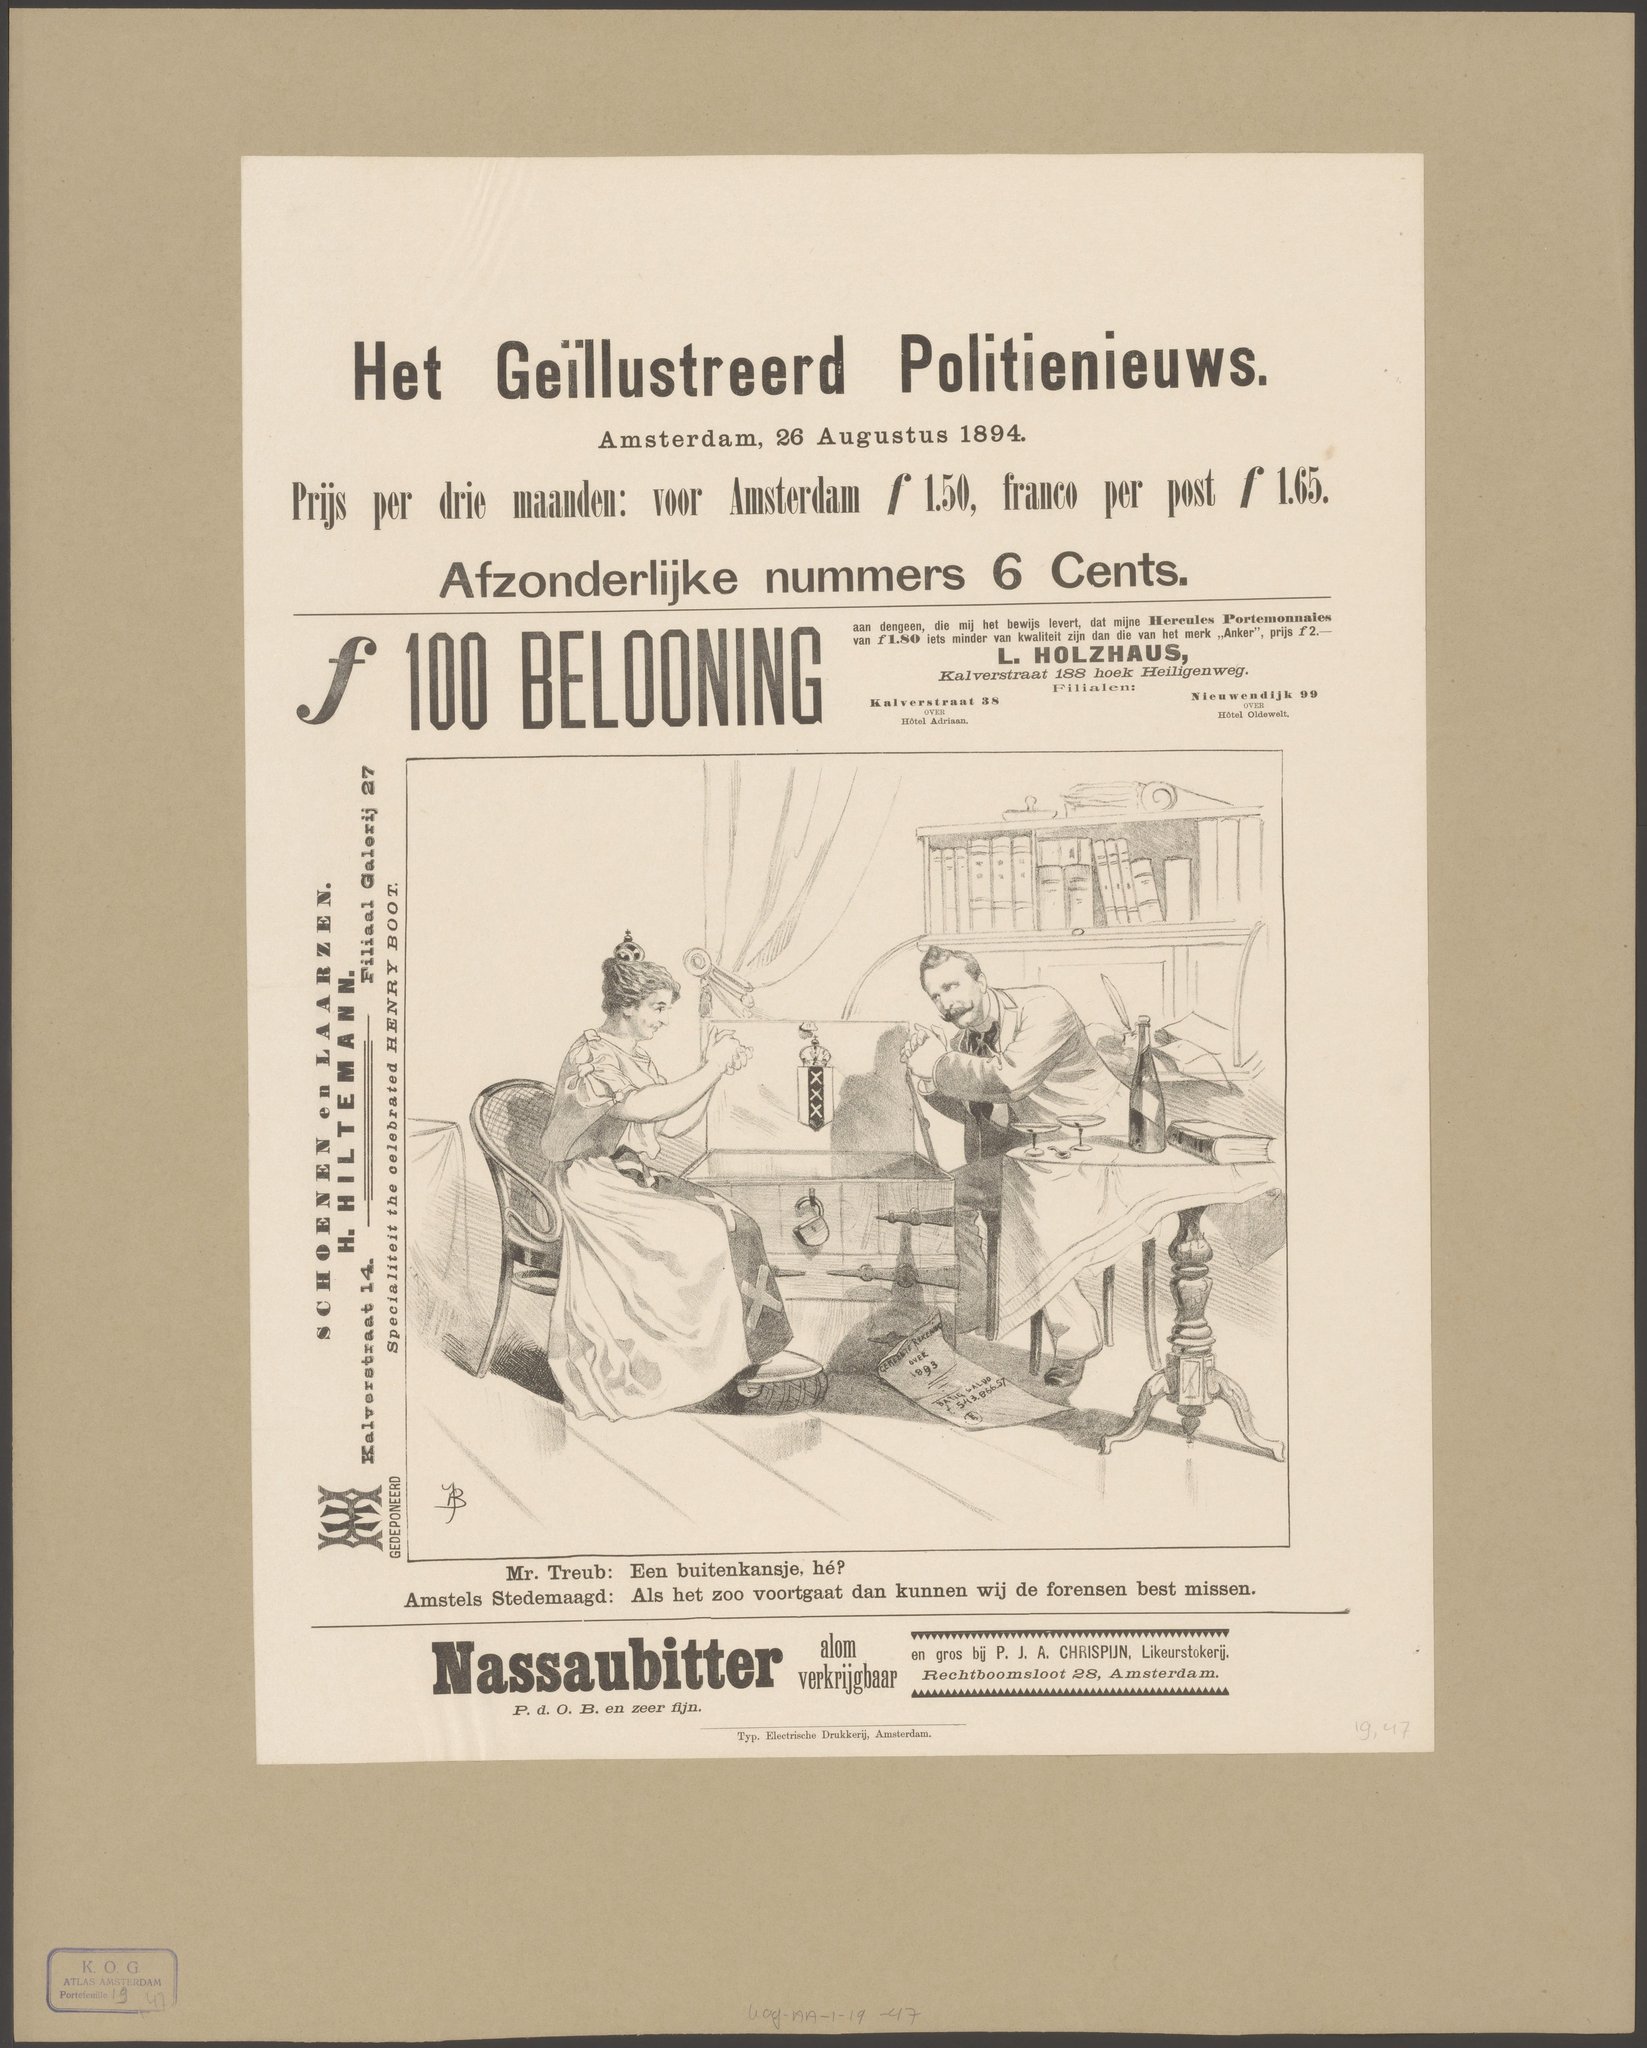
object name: cartoon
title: Spotprent op het financiële beleid van Willem Treub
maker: johan braakensiek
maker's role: draughtsman, print maker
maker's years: 1858-1940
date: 1894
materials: paper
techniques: letterpress printing, lithograph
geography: amsterdam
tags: politician, e.g. party leader, political caricatures and satires, amsterdam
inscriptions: collector's mark: ‘19,47’ Lugt 1641b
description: Onderwerpsrubriek binnen de Atlas Amsterdam: Herinneringen aan regeringsleden en hunne huisgezinnen [na 1800].